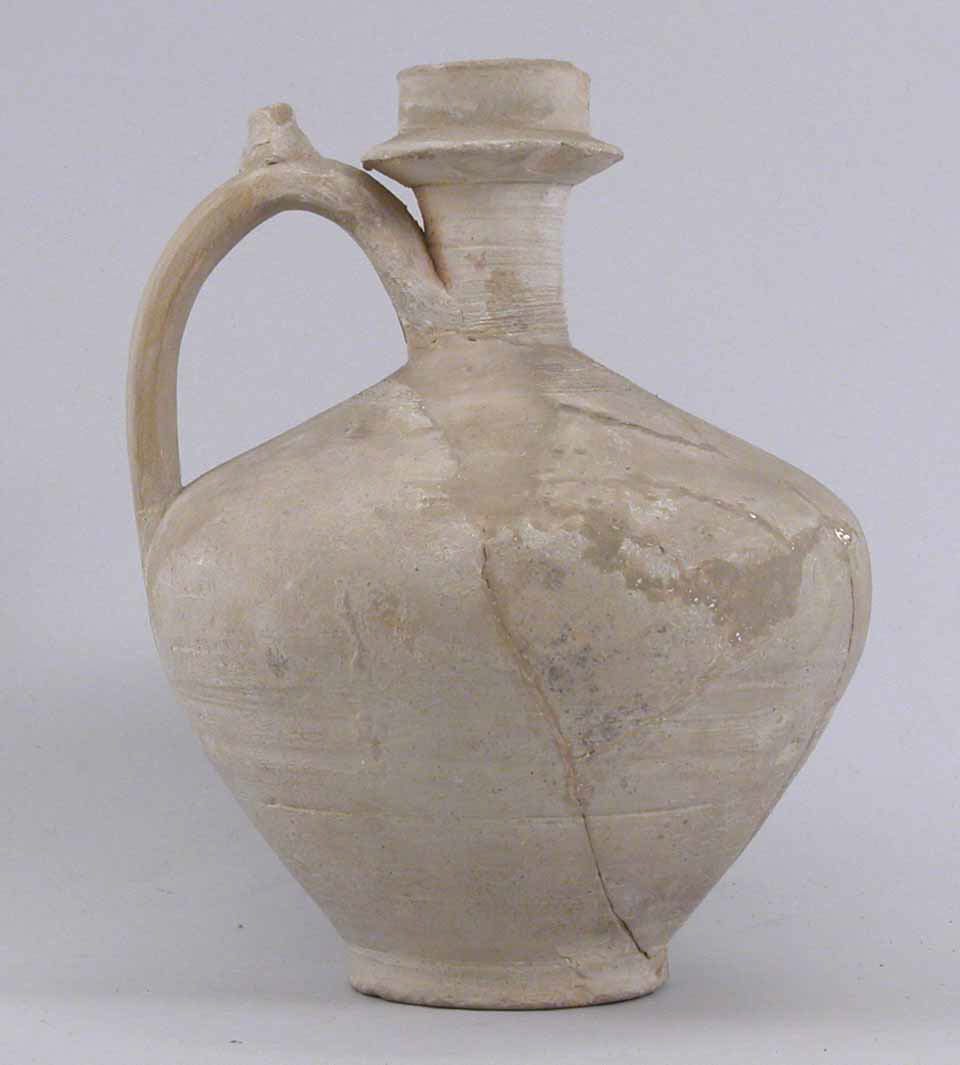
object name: ewer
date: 801-1000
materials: earthenware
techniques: molding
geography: iran